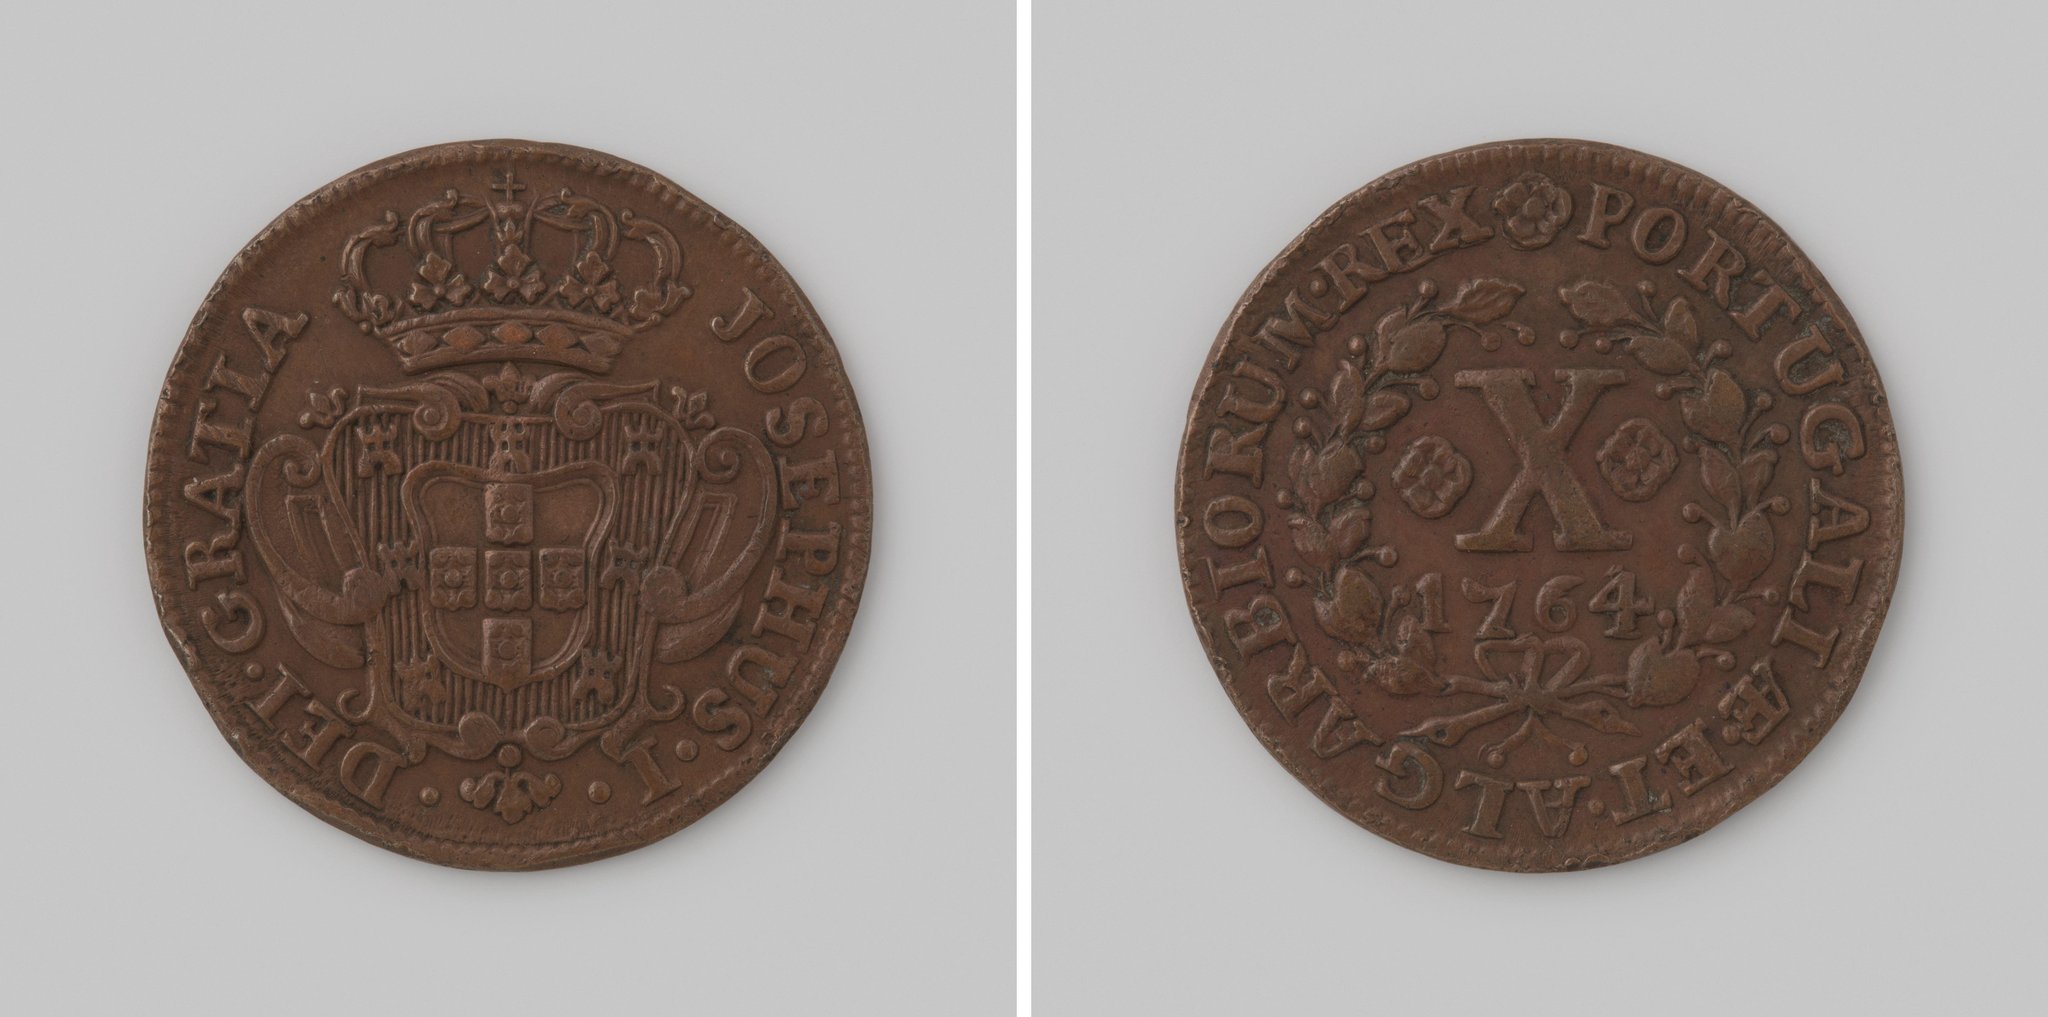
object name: coin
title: 10 reis uit Portugal van koning José I,1764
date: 1750-1777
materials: copper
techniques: striking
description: Koperen munt. Voorzijde: gekroond versierd wapenschild. Keerzijde: binnen twee samengebonden takken in een regel waarde-aanduiding: X, waaronder jaartal. Gladde rand.